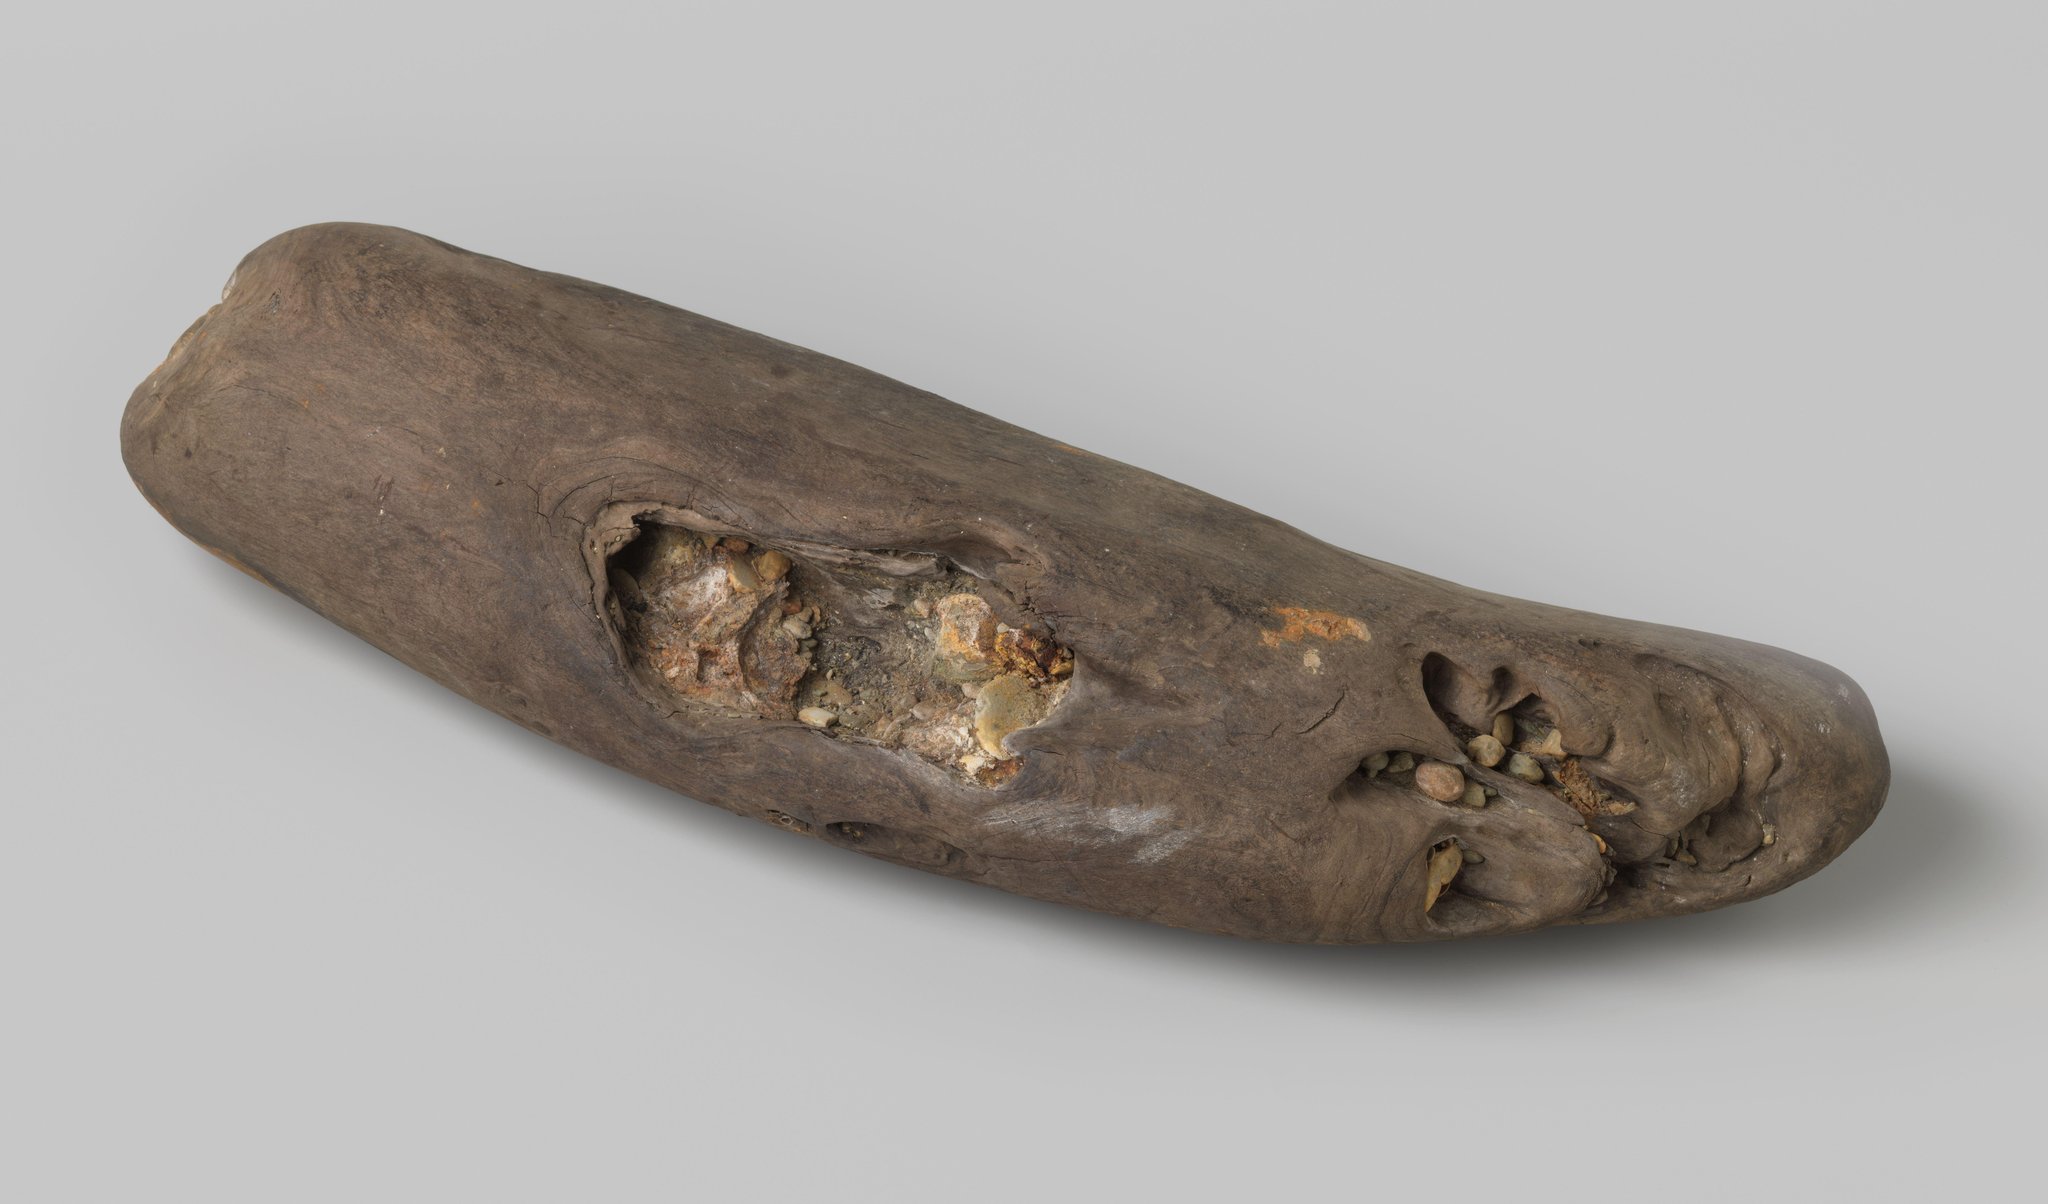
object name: verfhout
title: Paint wood (sappan) from the wreck of the Dutch East Indiaman Boot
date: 1735-1738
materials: wood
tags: boot (schip), verenigde oostindische compagnie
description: Het stuk sappanhout is afkomstig uit het wrak van het VOC-retourschip (hekboot) 'Boot', dat op 8 november 1738 op de zesde reis bij Prawle Point (Zuid-Devon/Groot Brittannië) is vergaan. Het schip was op 2 april 1738 uit Batavia vertrokken, arriveerde op 31 juli op Kaap de Goede Hoop (Zuid-Afrika) en vertrok daarvandaan op 12 augustus met de bestemming Amsterdam. De hekboot 'Boot' was in 1733 voor de VOC-Kamer Rotterdam te Rotterdam gebouwd en mat 650 ton. Het maakte reizen voor de VOC-kamers Rotterdam, Zeeland en Amsterdam. De Belgische berger Robert Sténuit heeft objecten uit dit wrak geborgen en dit stuk aan het Rijksmuseum geschonken.